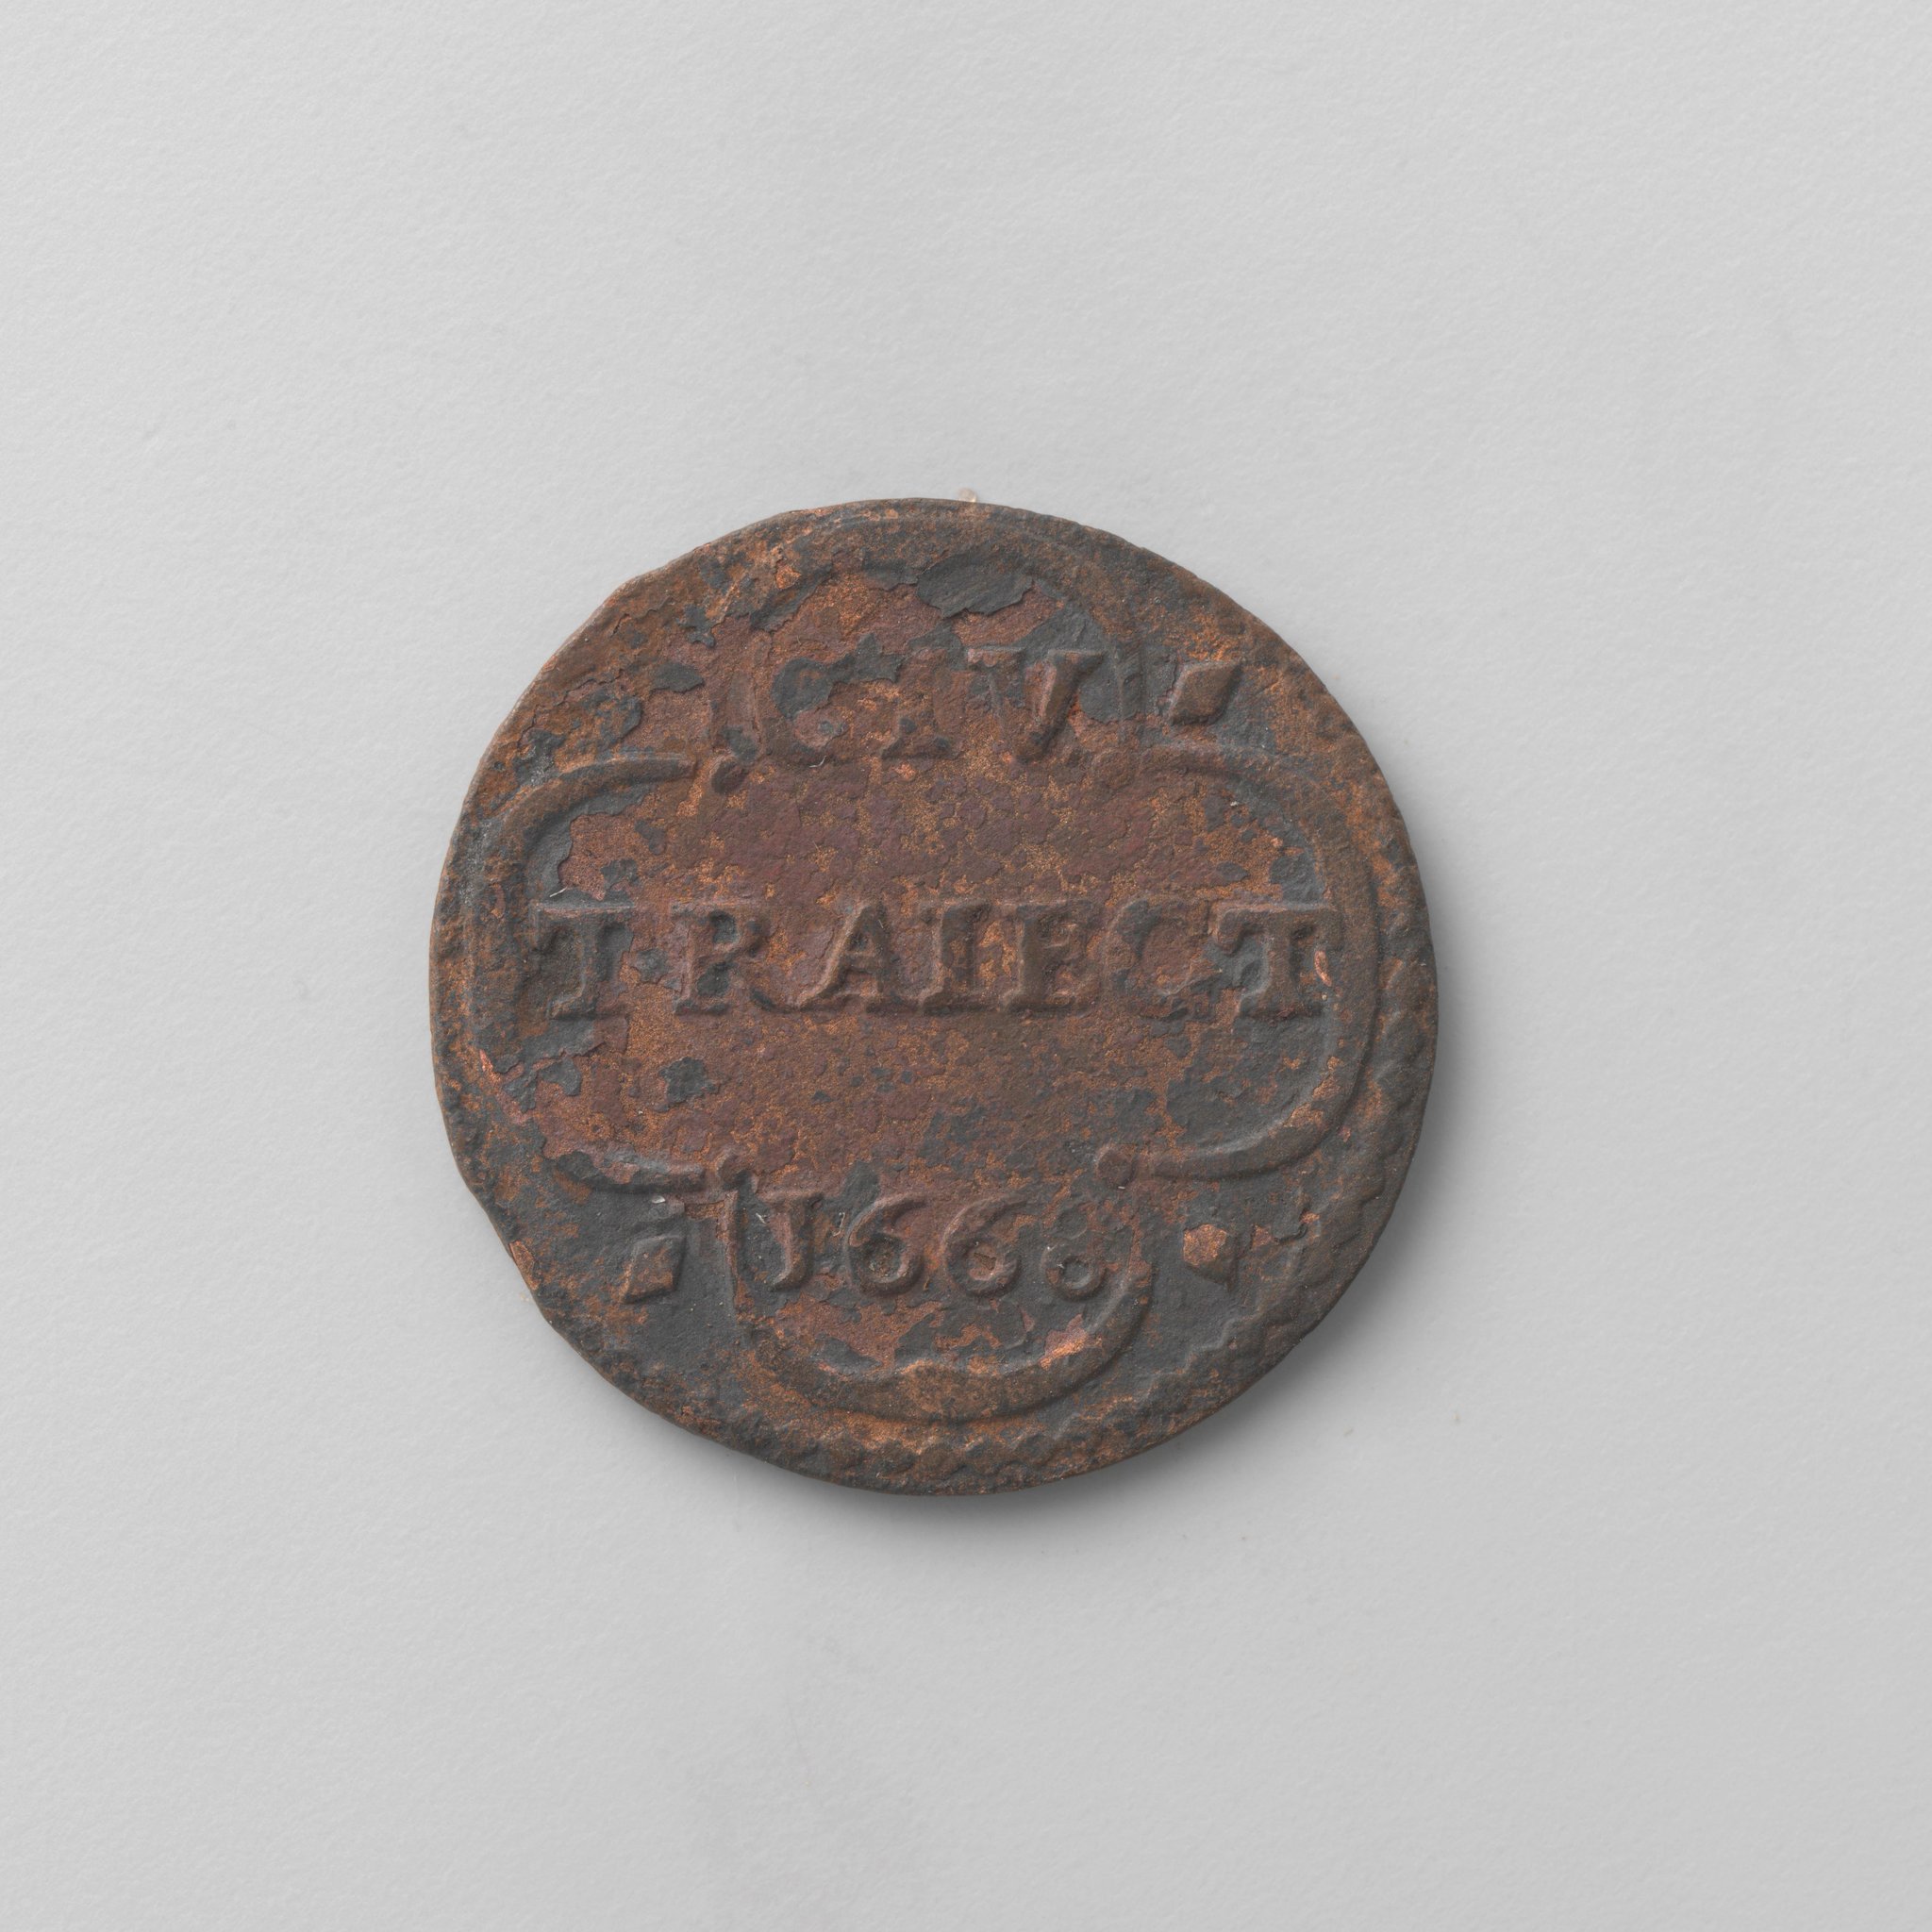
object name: coin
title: Duit van de stad Utrecht, 1668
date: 1668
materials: copper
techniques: striking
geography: utrecht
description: Koperen munt. Voorzijde: gekroond stedelijk, horizontaal gearceeerd wapenschild, gehouden door twee leeuwen. Keerzijde: binnen een versierde vierpas opschrift in twee regels, waaronder jaartal.